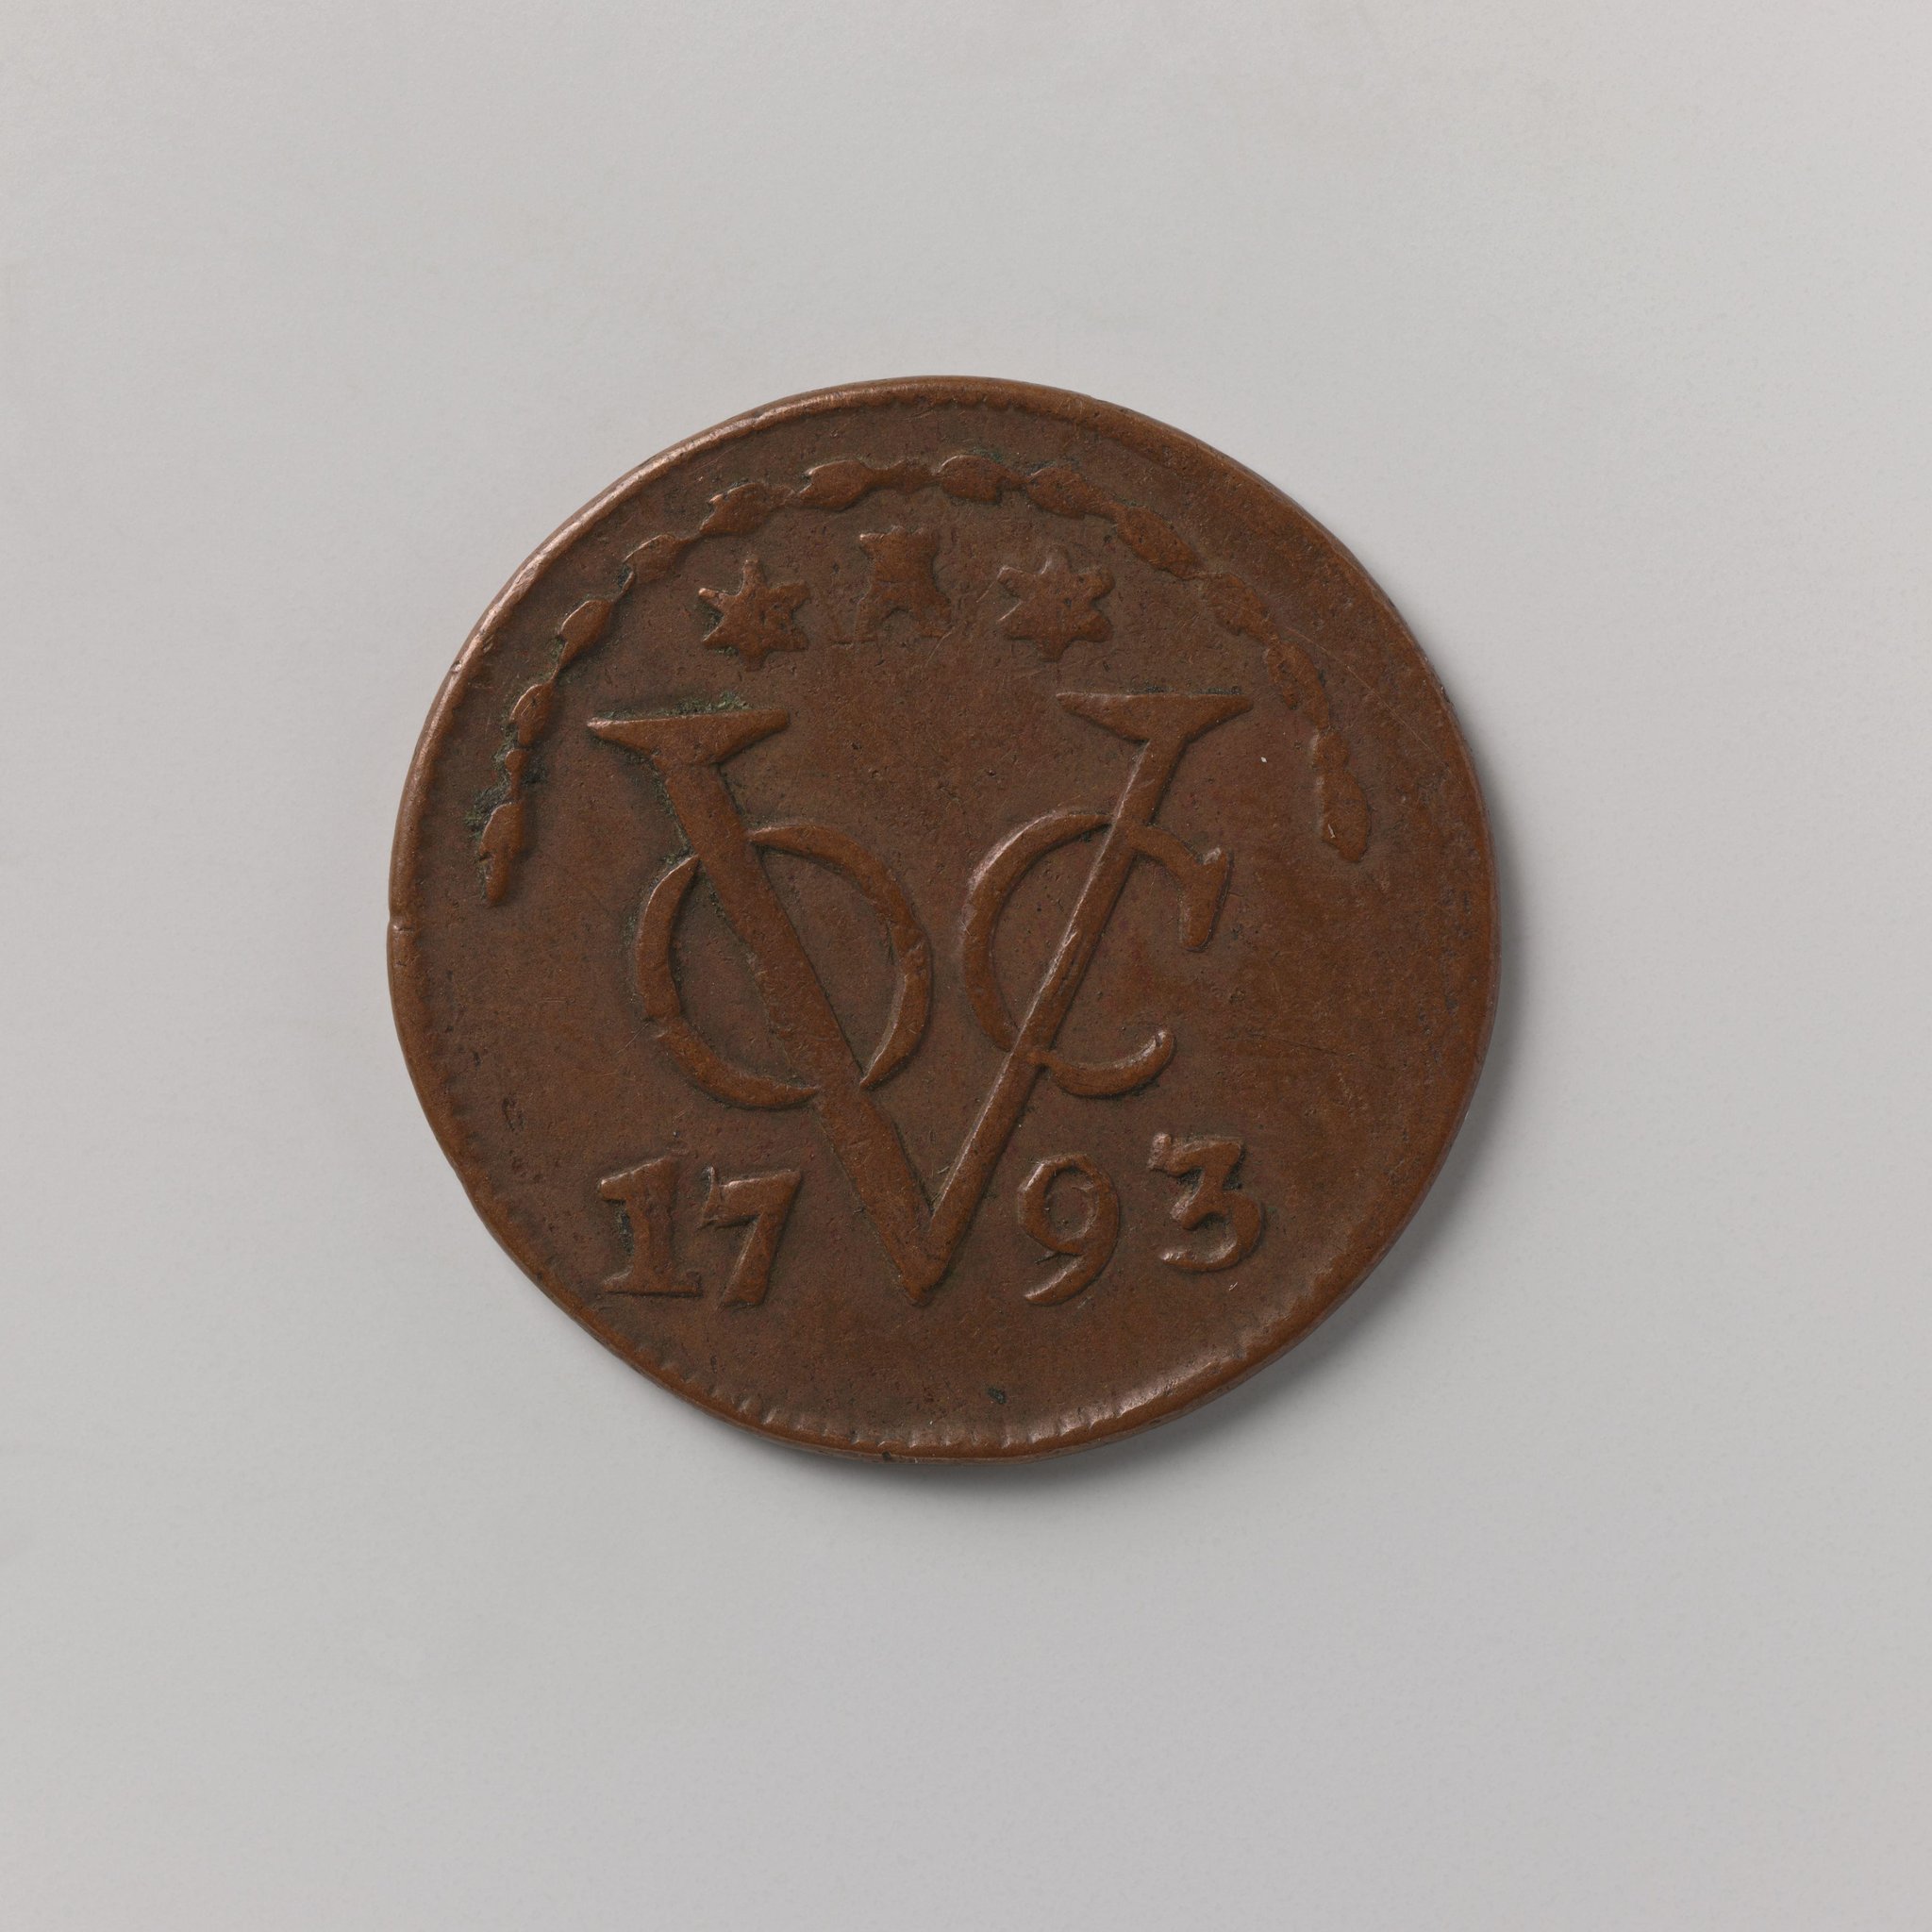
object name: coin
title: Duit van de VOC uit Zeeland, 1793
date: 1793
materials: copper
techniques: striking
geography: middelburg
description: Koperen munt. Voorzijde: driehoekig ingebogen en in een punt uitlopend gekroond wapenschild van Zeeland. Keerzijde: monogram van de VOC, waarboven onder halve bladerkrans muntteken en waaronder jaartal. Gladde rand.